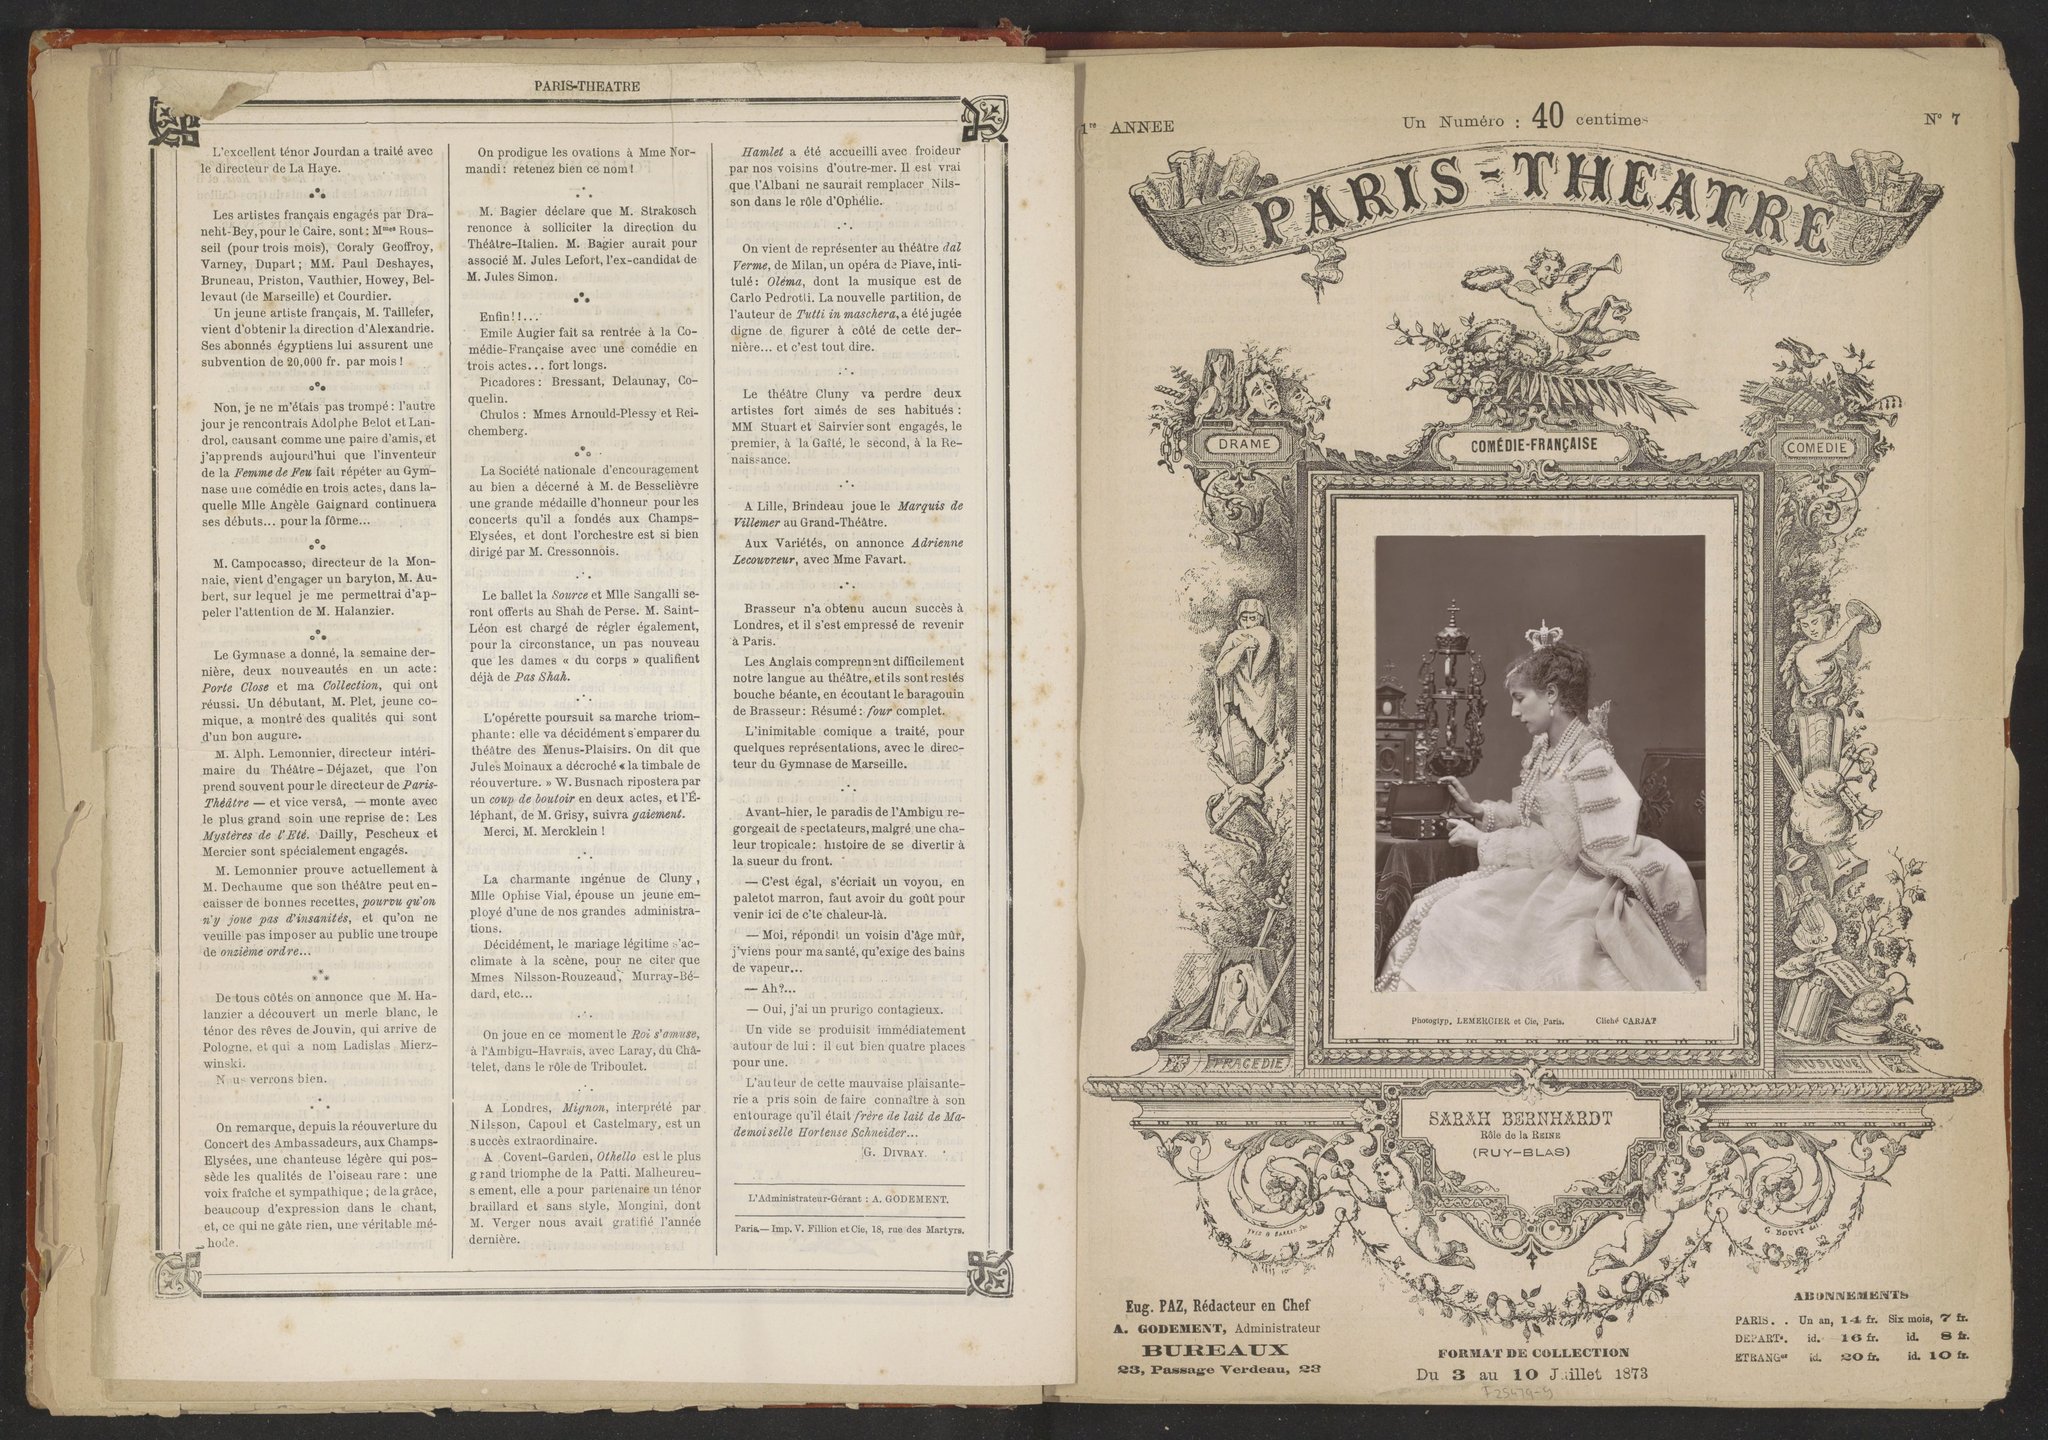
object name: page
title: Portret van Sarah Bernhardt als Doña Maira de Neubourg in Ruy Blas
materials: paper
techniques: woodburytype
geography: france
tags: paris, sarah bernhardt, interior ~ representation of a building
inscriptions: inscription: ‘Du 3 au 10 Juillet 1873’, number: ‘No 7’